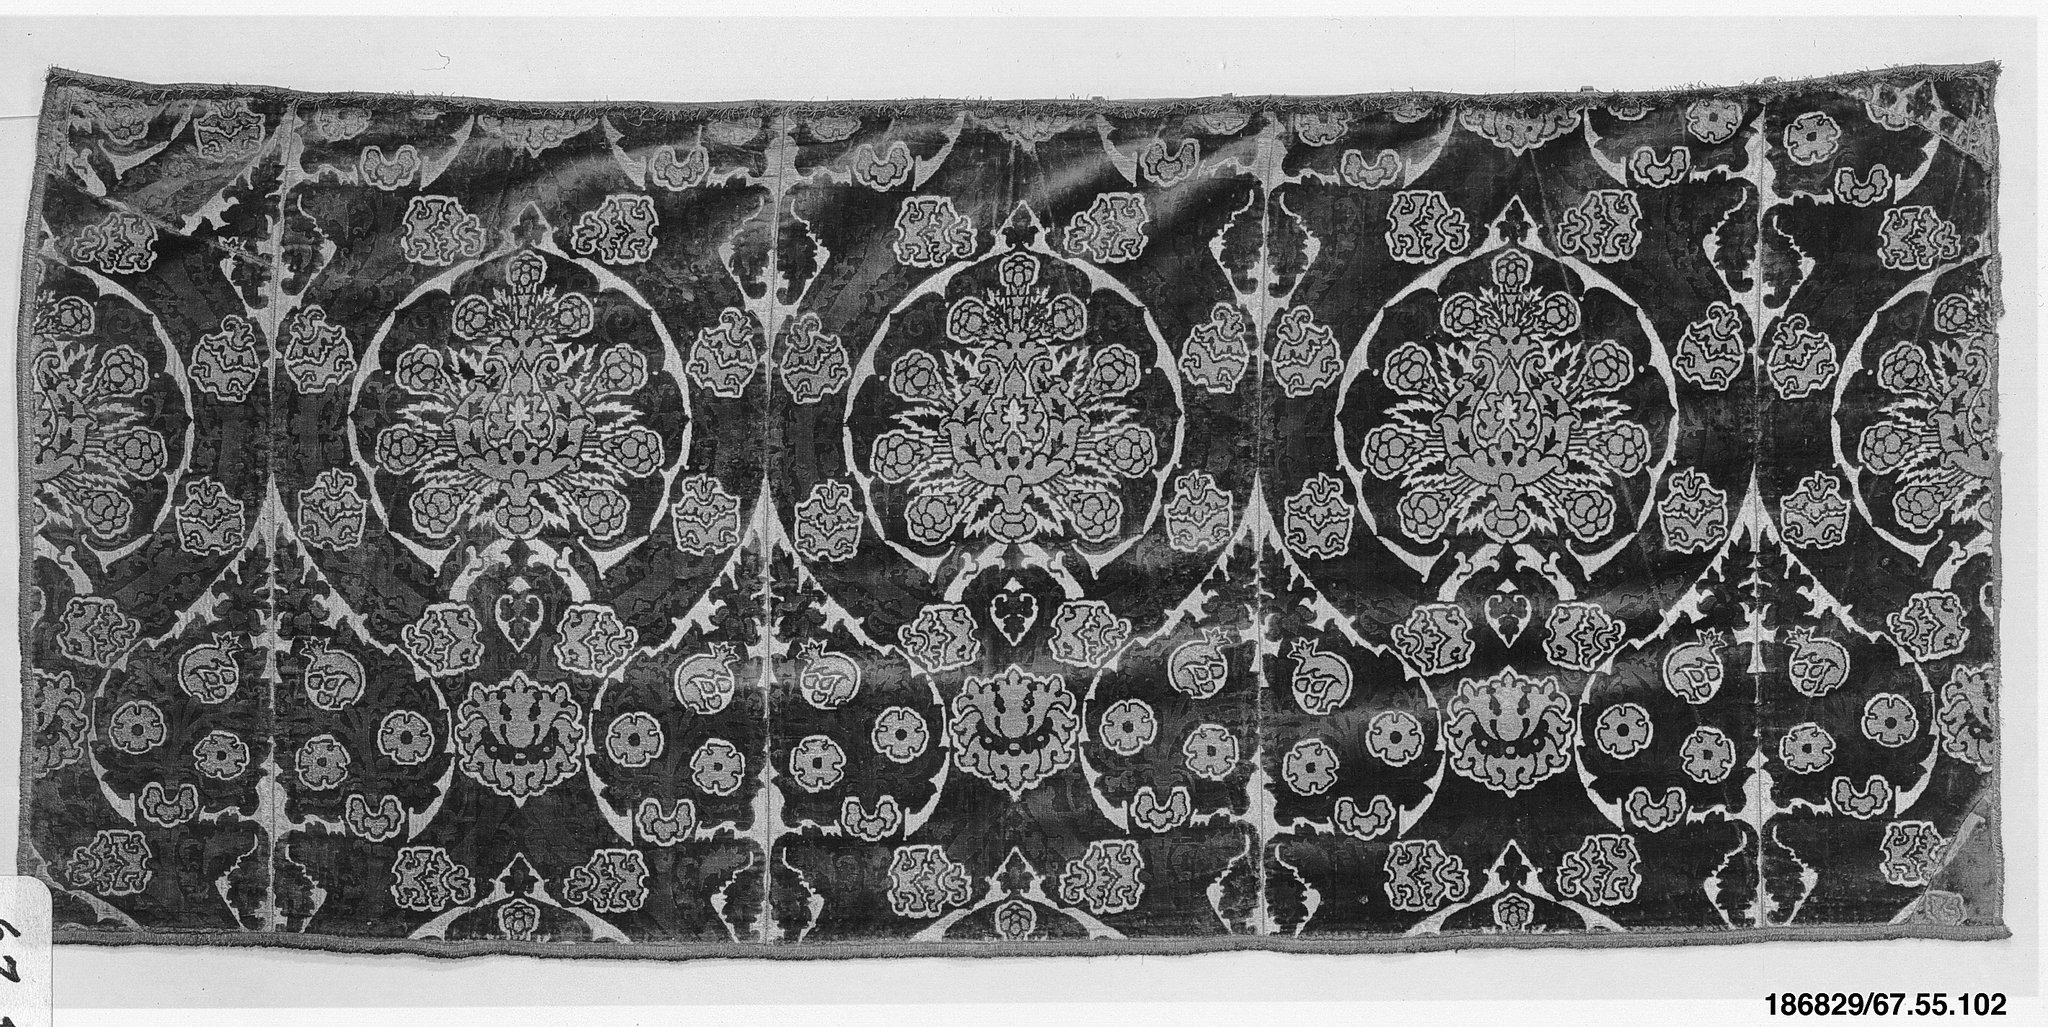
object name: antependium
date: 1501-1600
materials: metal thread, silk